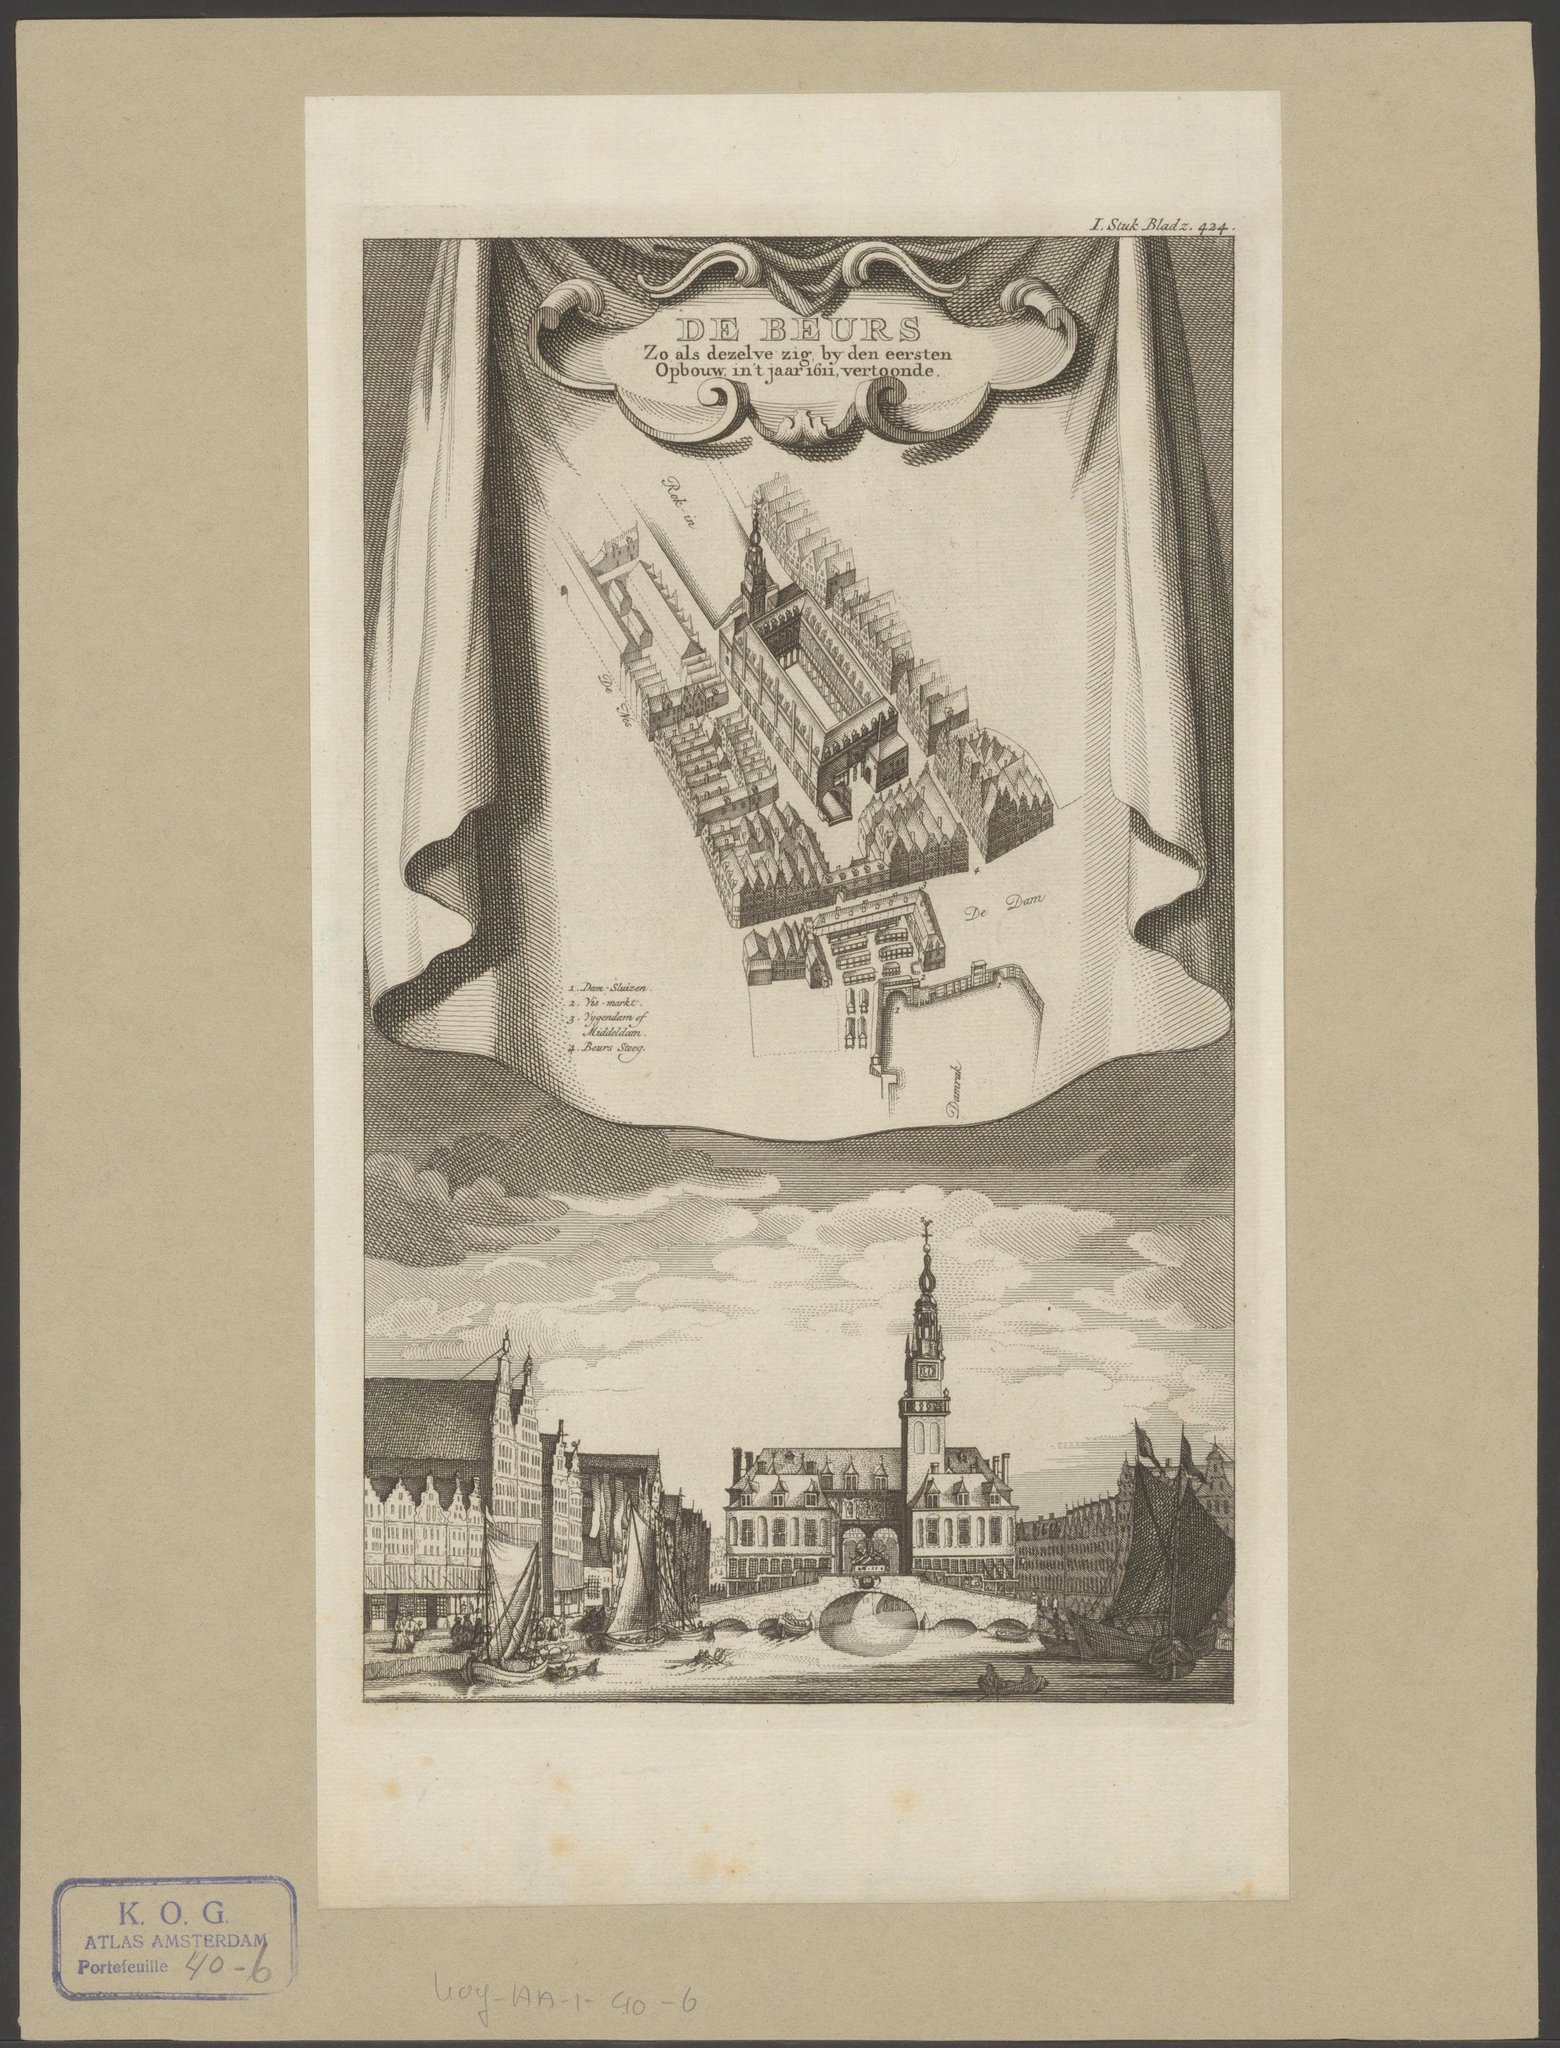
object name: print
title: De Beurs Zo als dezelve zig, by den eersten Opbouw, in 't jaar 1611, vertoonde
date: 1760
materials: paper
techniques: engraving, etching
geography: amsterdam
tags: stock exchange, stock-market, canals, waters (in city) (+ city(-scape) with figures, staffage)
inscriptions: collector's mark: Lugt 1641b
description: Gezicht in vogelvlucht en gezicht op de Beurs van Hendrik de Keyser op het Rokin te Amsterdam, in de situatie in 1611. Boven in het midden de titelcartouche. Links onder het gezicht in vogelvlucht de legenda 1-4. Rechtsboven gemerkt: I. Stuk Bladz. 424. Onderwerpsrubriek binnen de Atlas Amsterdam: Handel en Zeevaart: Beurs op het Rokin.